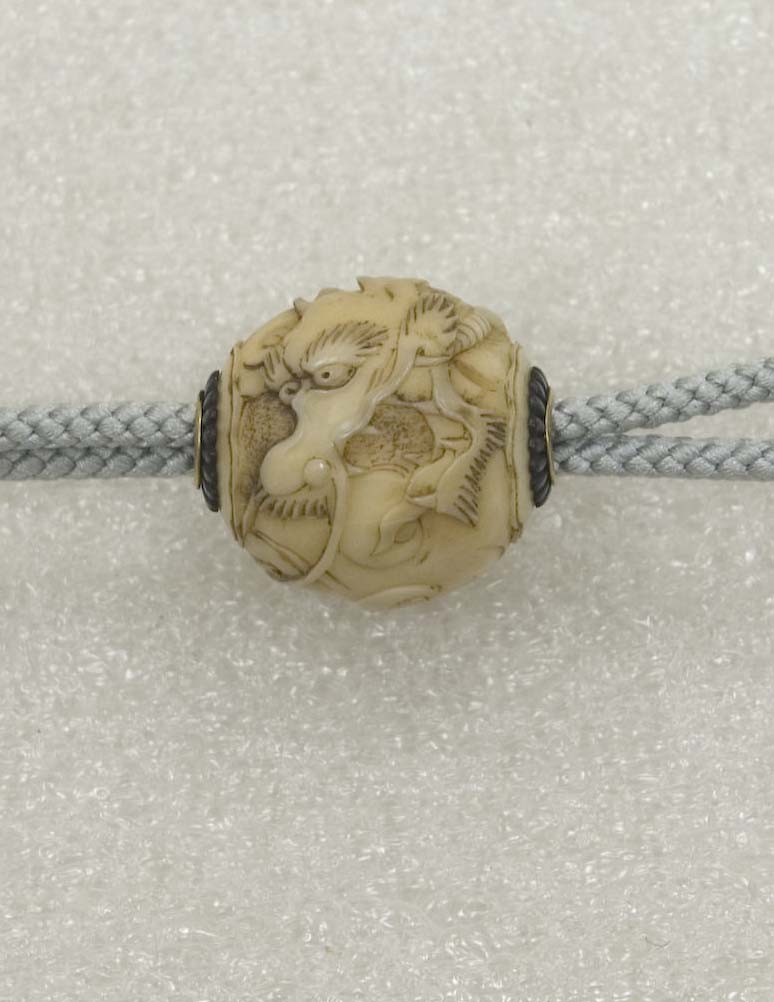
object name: bead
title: Carved Bead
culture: japanese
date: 1801-1900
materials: ivory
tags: dragons